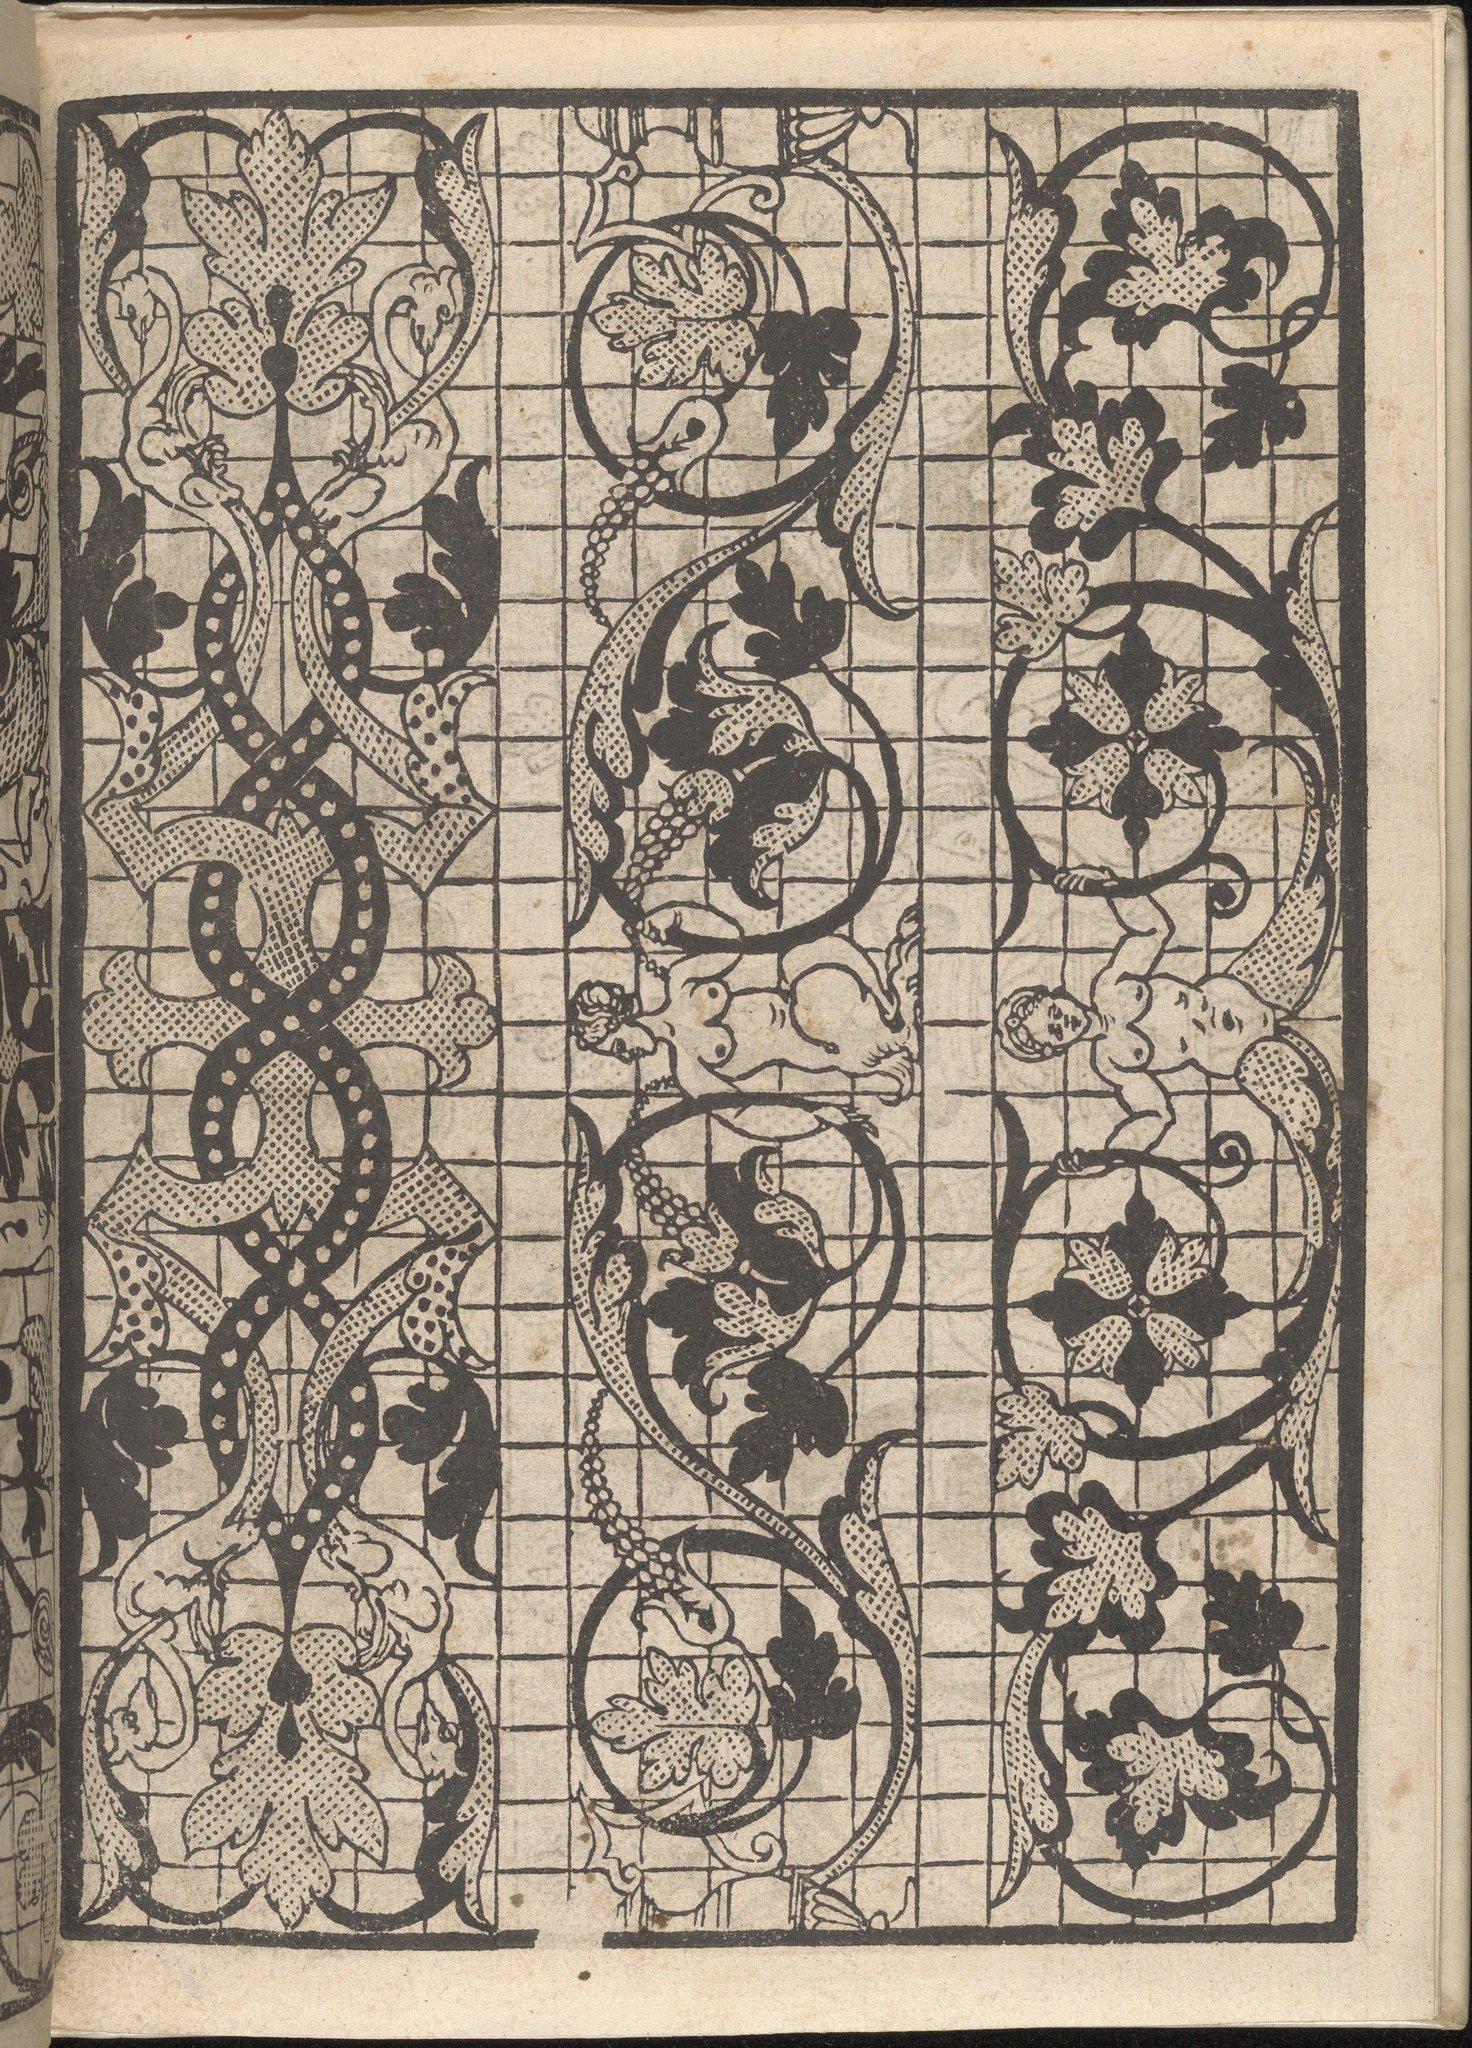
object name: book print ornament architecture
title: Splendore delle virtuose giovani, page 16 (recto)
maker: iseppo foresto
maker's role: designer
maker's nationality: italian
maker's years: 1520-1580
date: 1564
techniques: woodcut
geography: italy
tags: female nudes,dragons,flowers